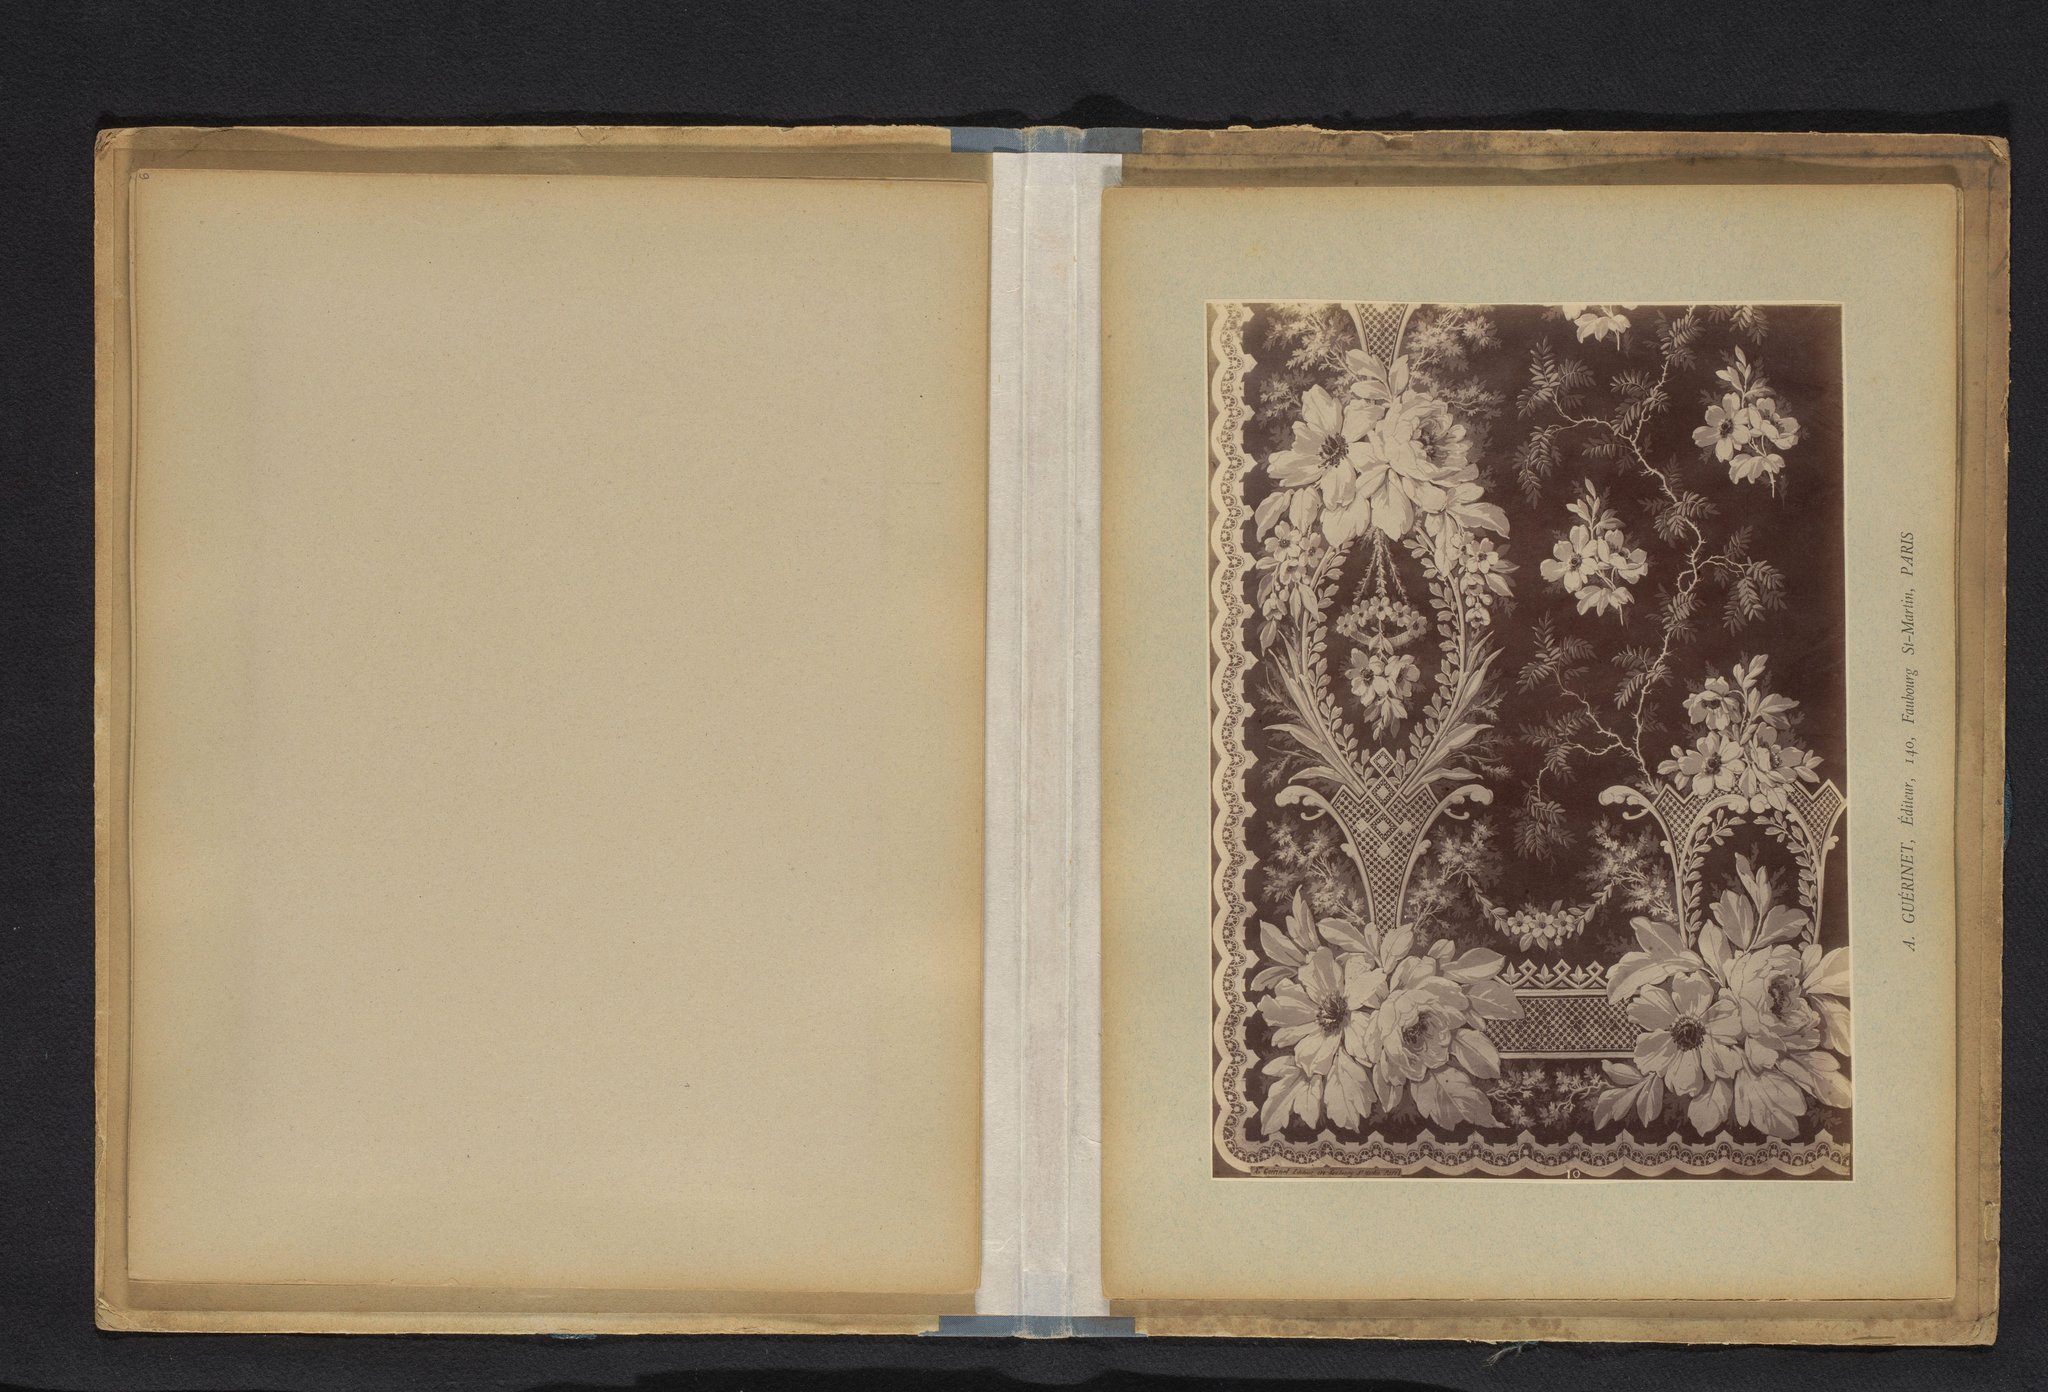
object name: photograph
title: Fotoreproductie van een decoratief patroon met bloemen en bladeren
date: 1890-1900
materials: photographic support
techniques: albumen print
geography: paris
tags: ornament derived from plant forms, flowers ~ ornament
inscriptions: number: ‘10’